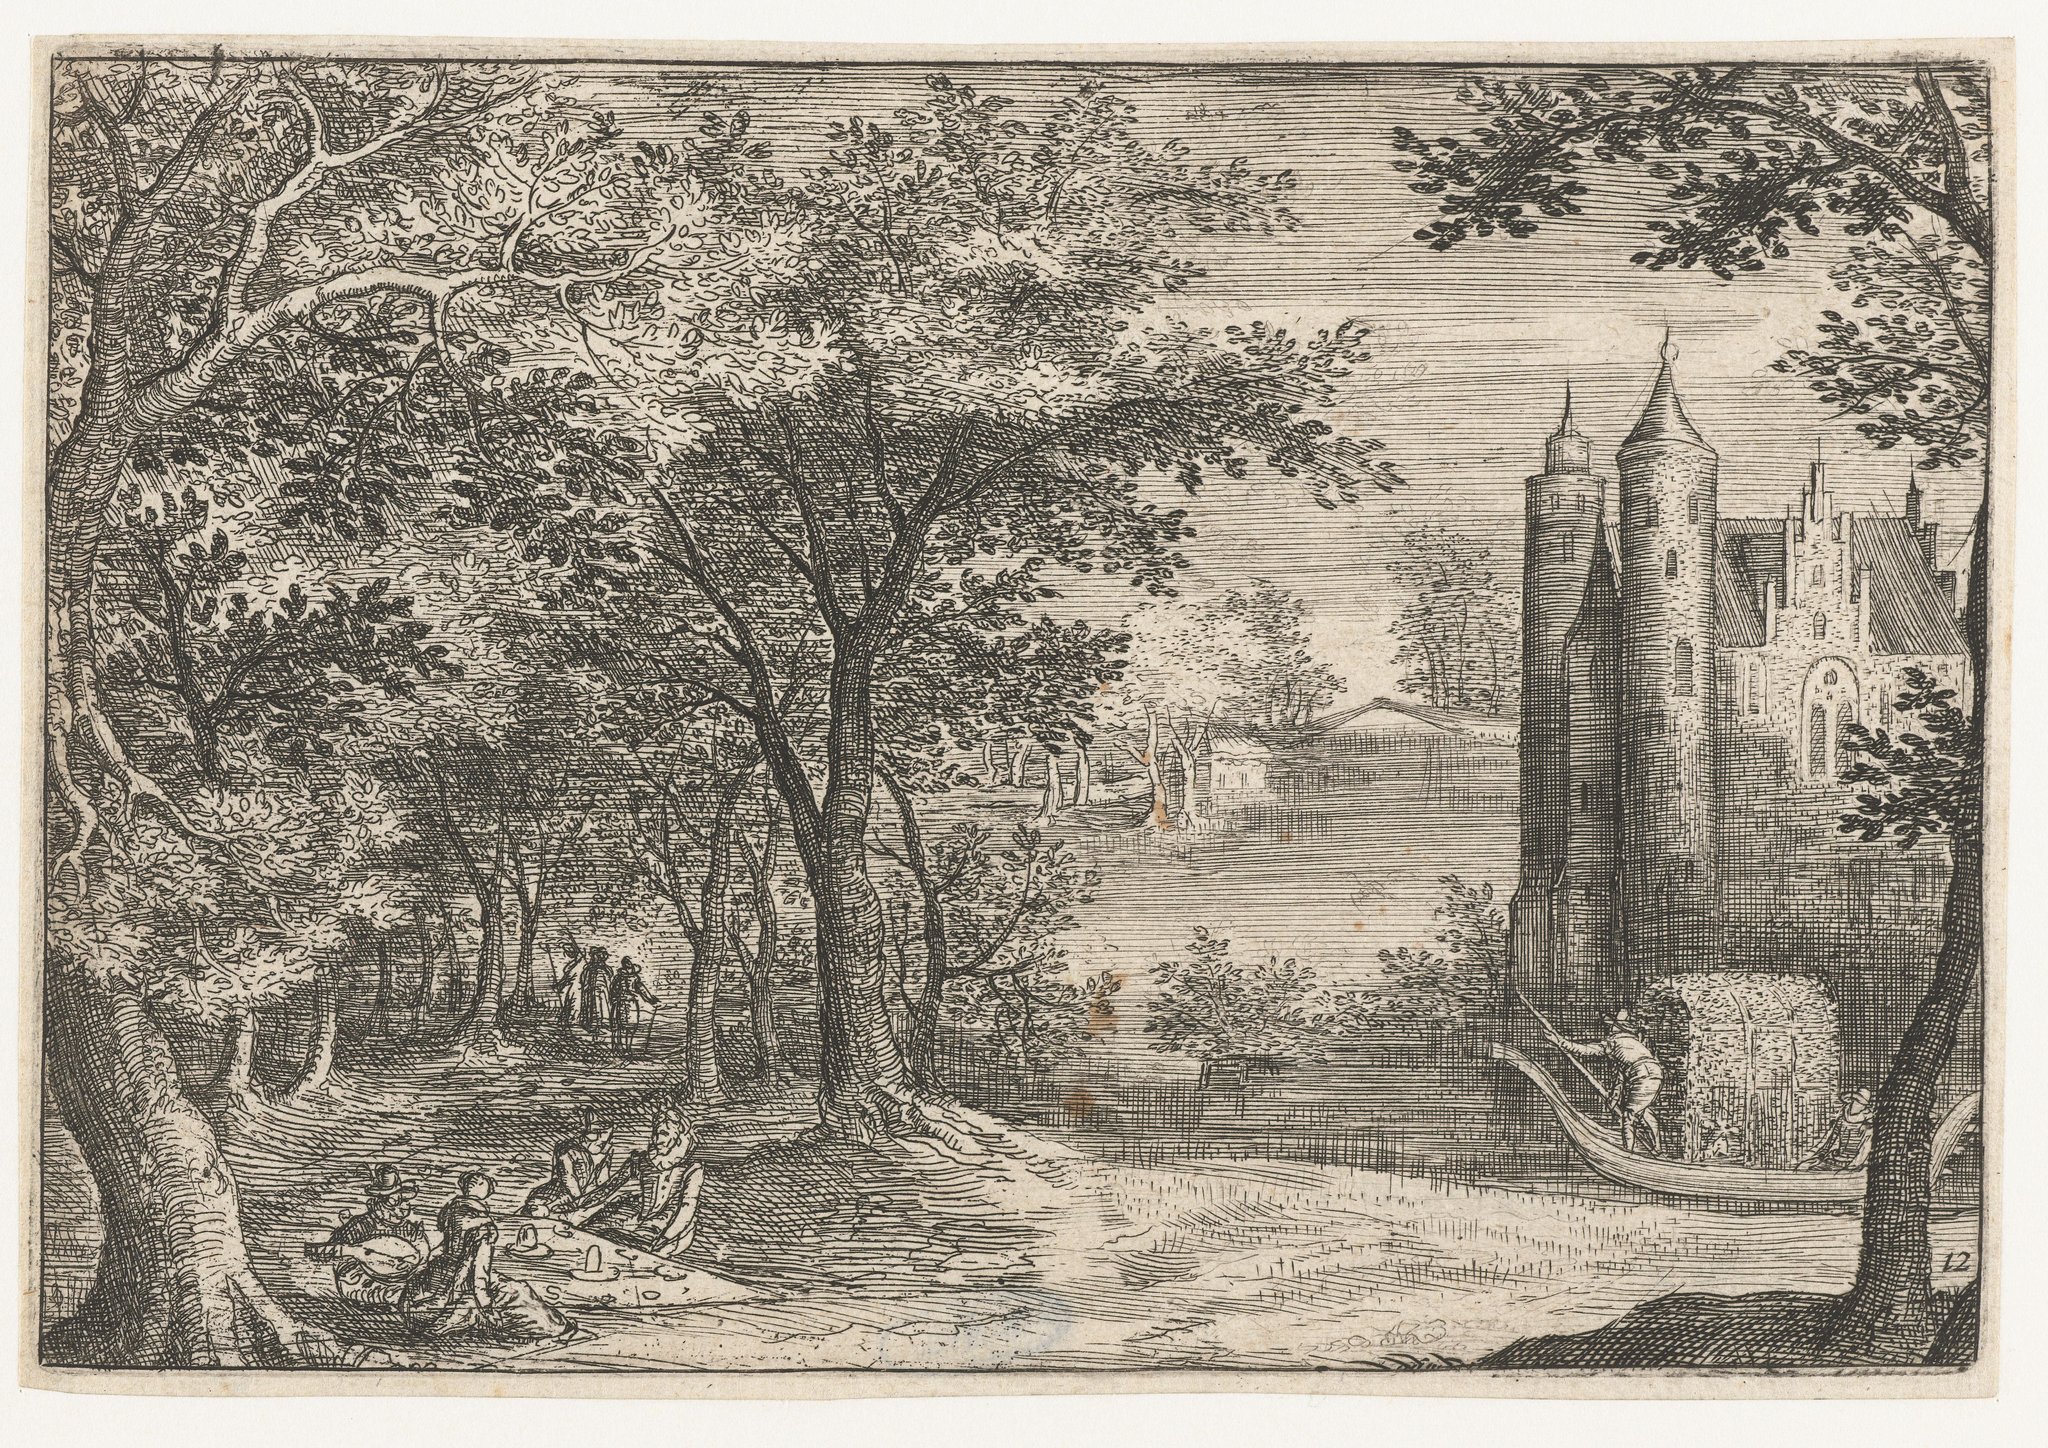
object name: print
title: Picknick aan de bosrand bij een kasteel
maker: Anonymous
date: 1575-1650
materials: paper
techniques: etching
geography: low countries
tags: picnic, alfresco, 'déjeuner sur l'herbe', private festivities, merry company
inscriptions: collector's mark: Lugt 742, collector's mark: Lugt 2228a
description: Twee stellen picknicken, gezeten aan een bosrand. Rechts een kasteel aan een water.